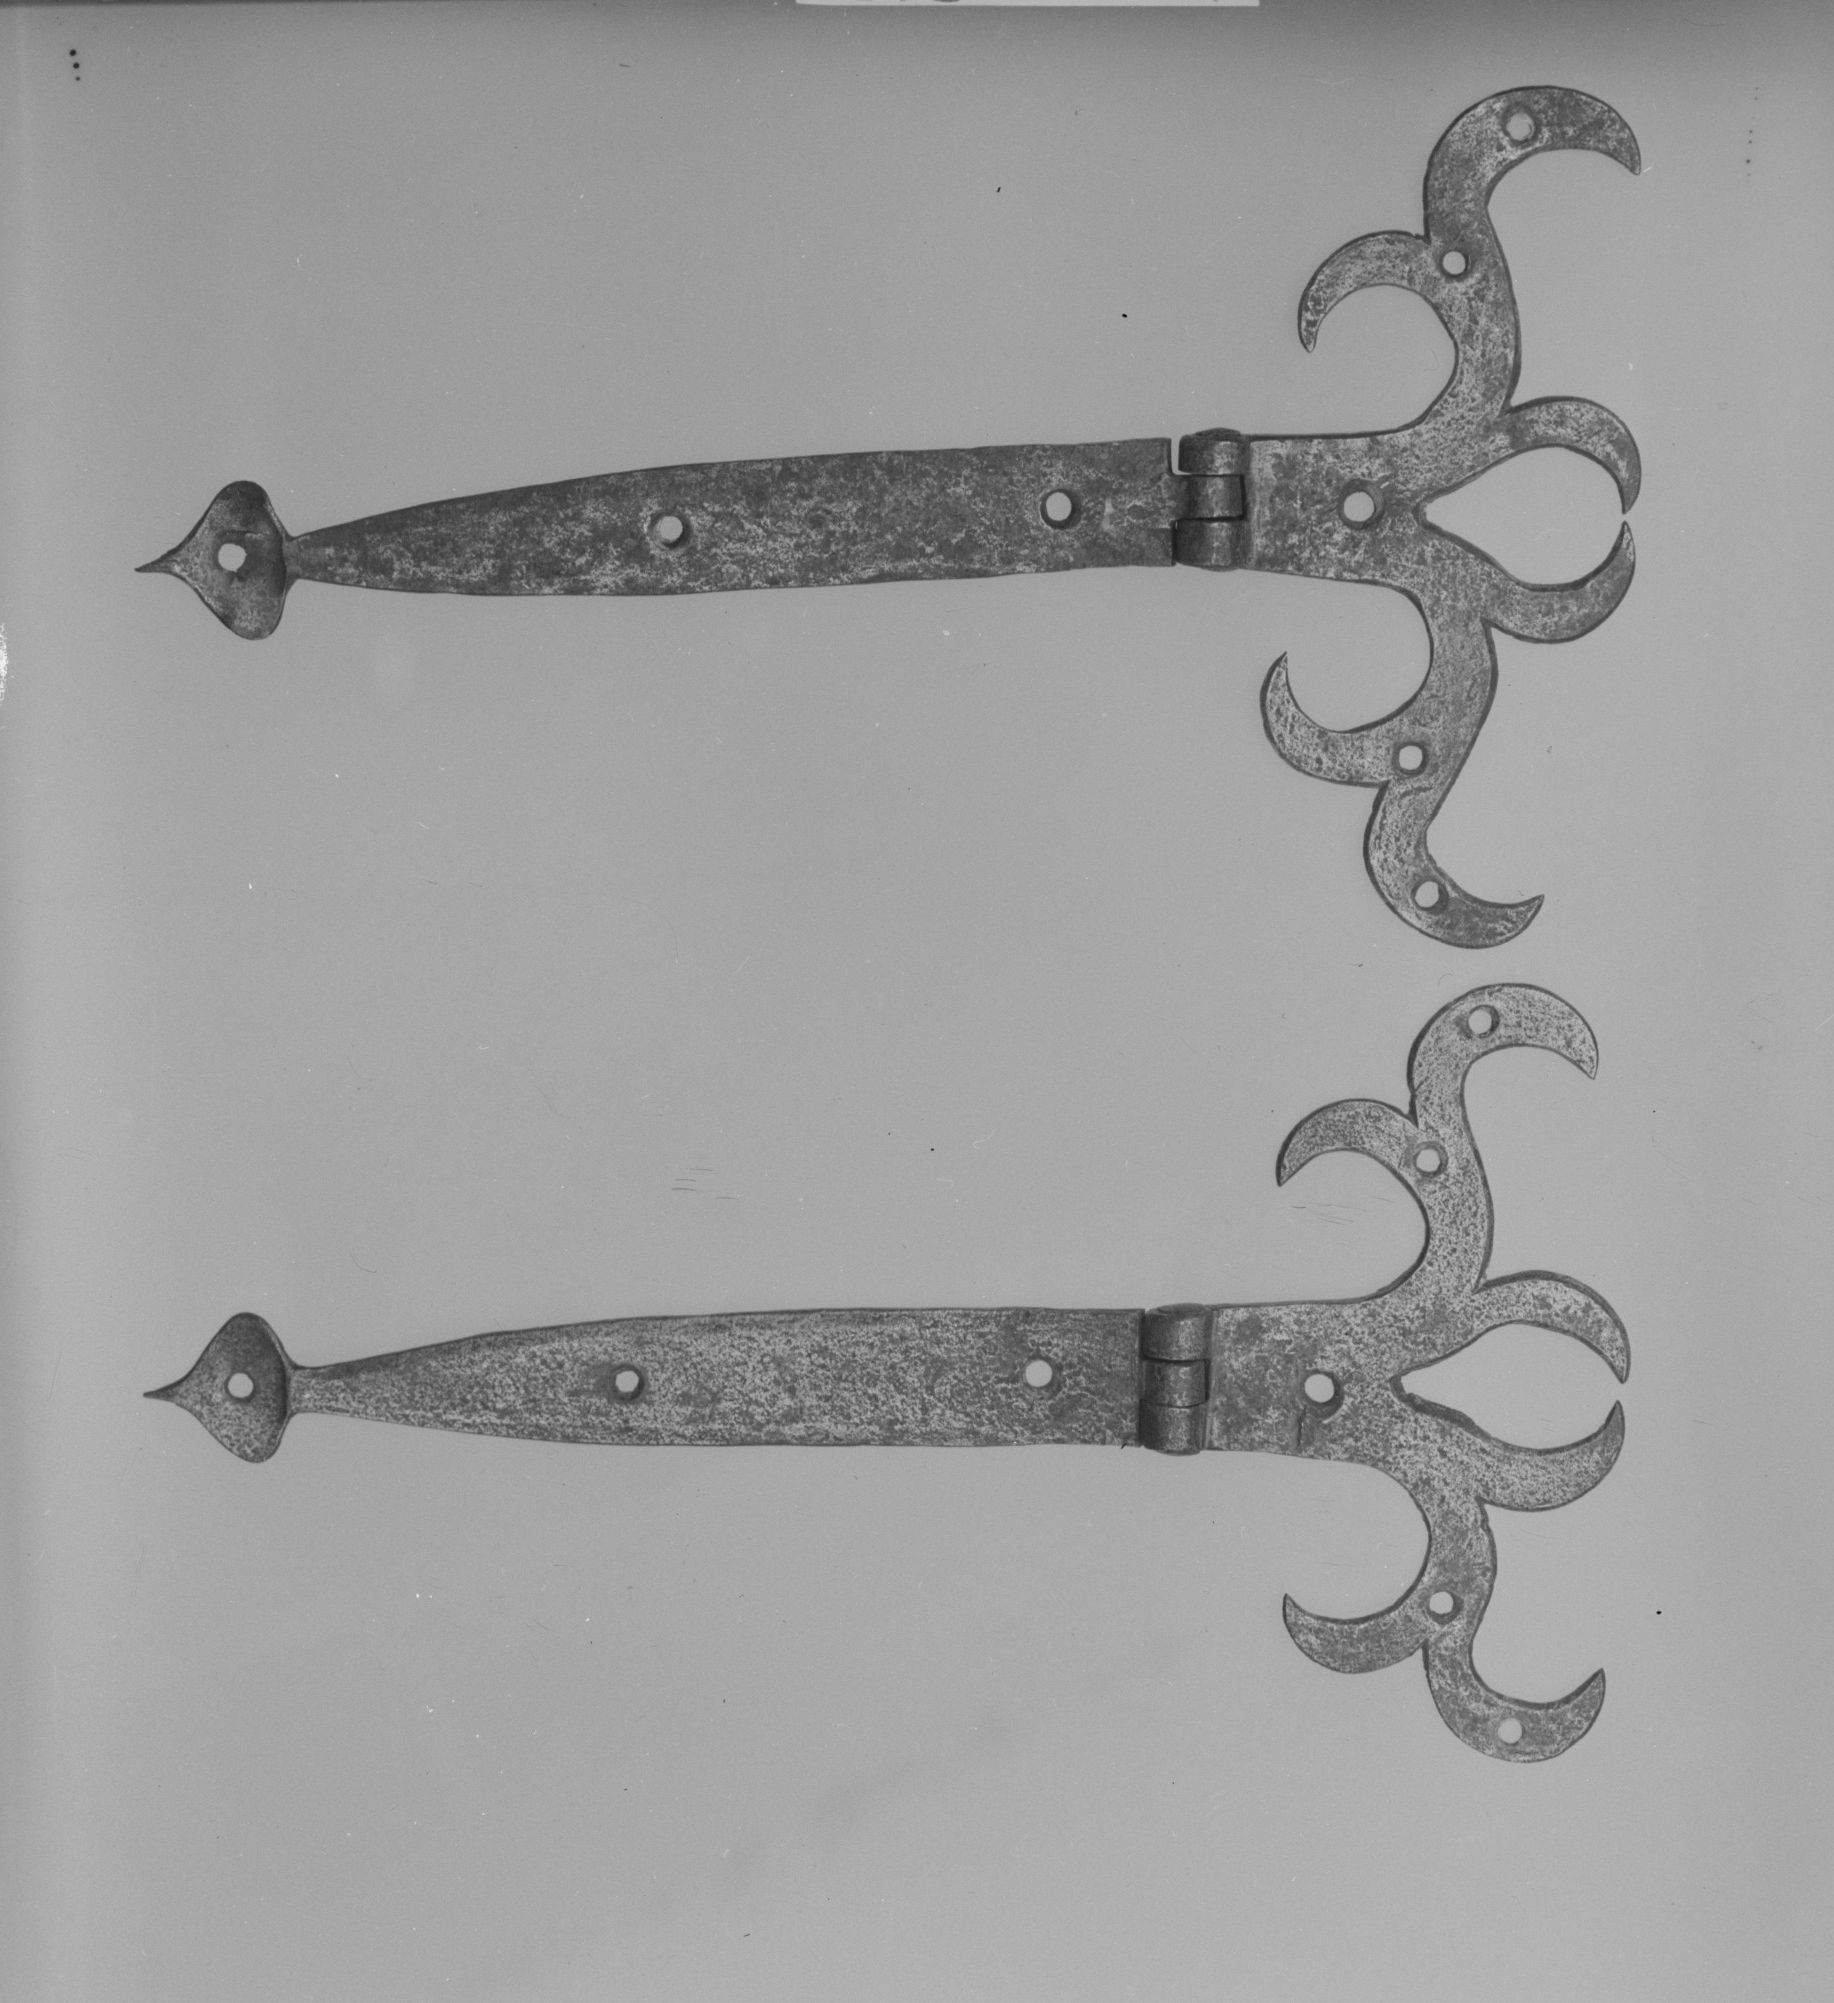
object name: hinge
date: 1700-1800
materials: iron